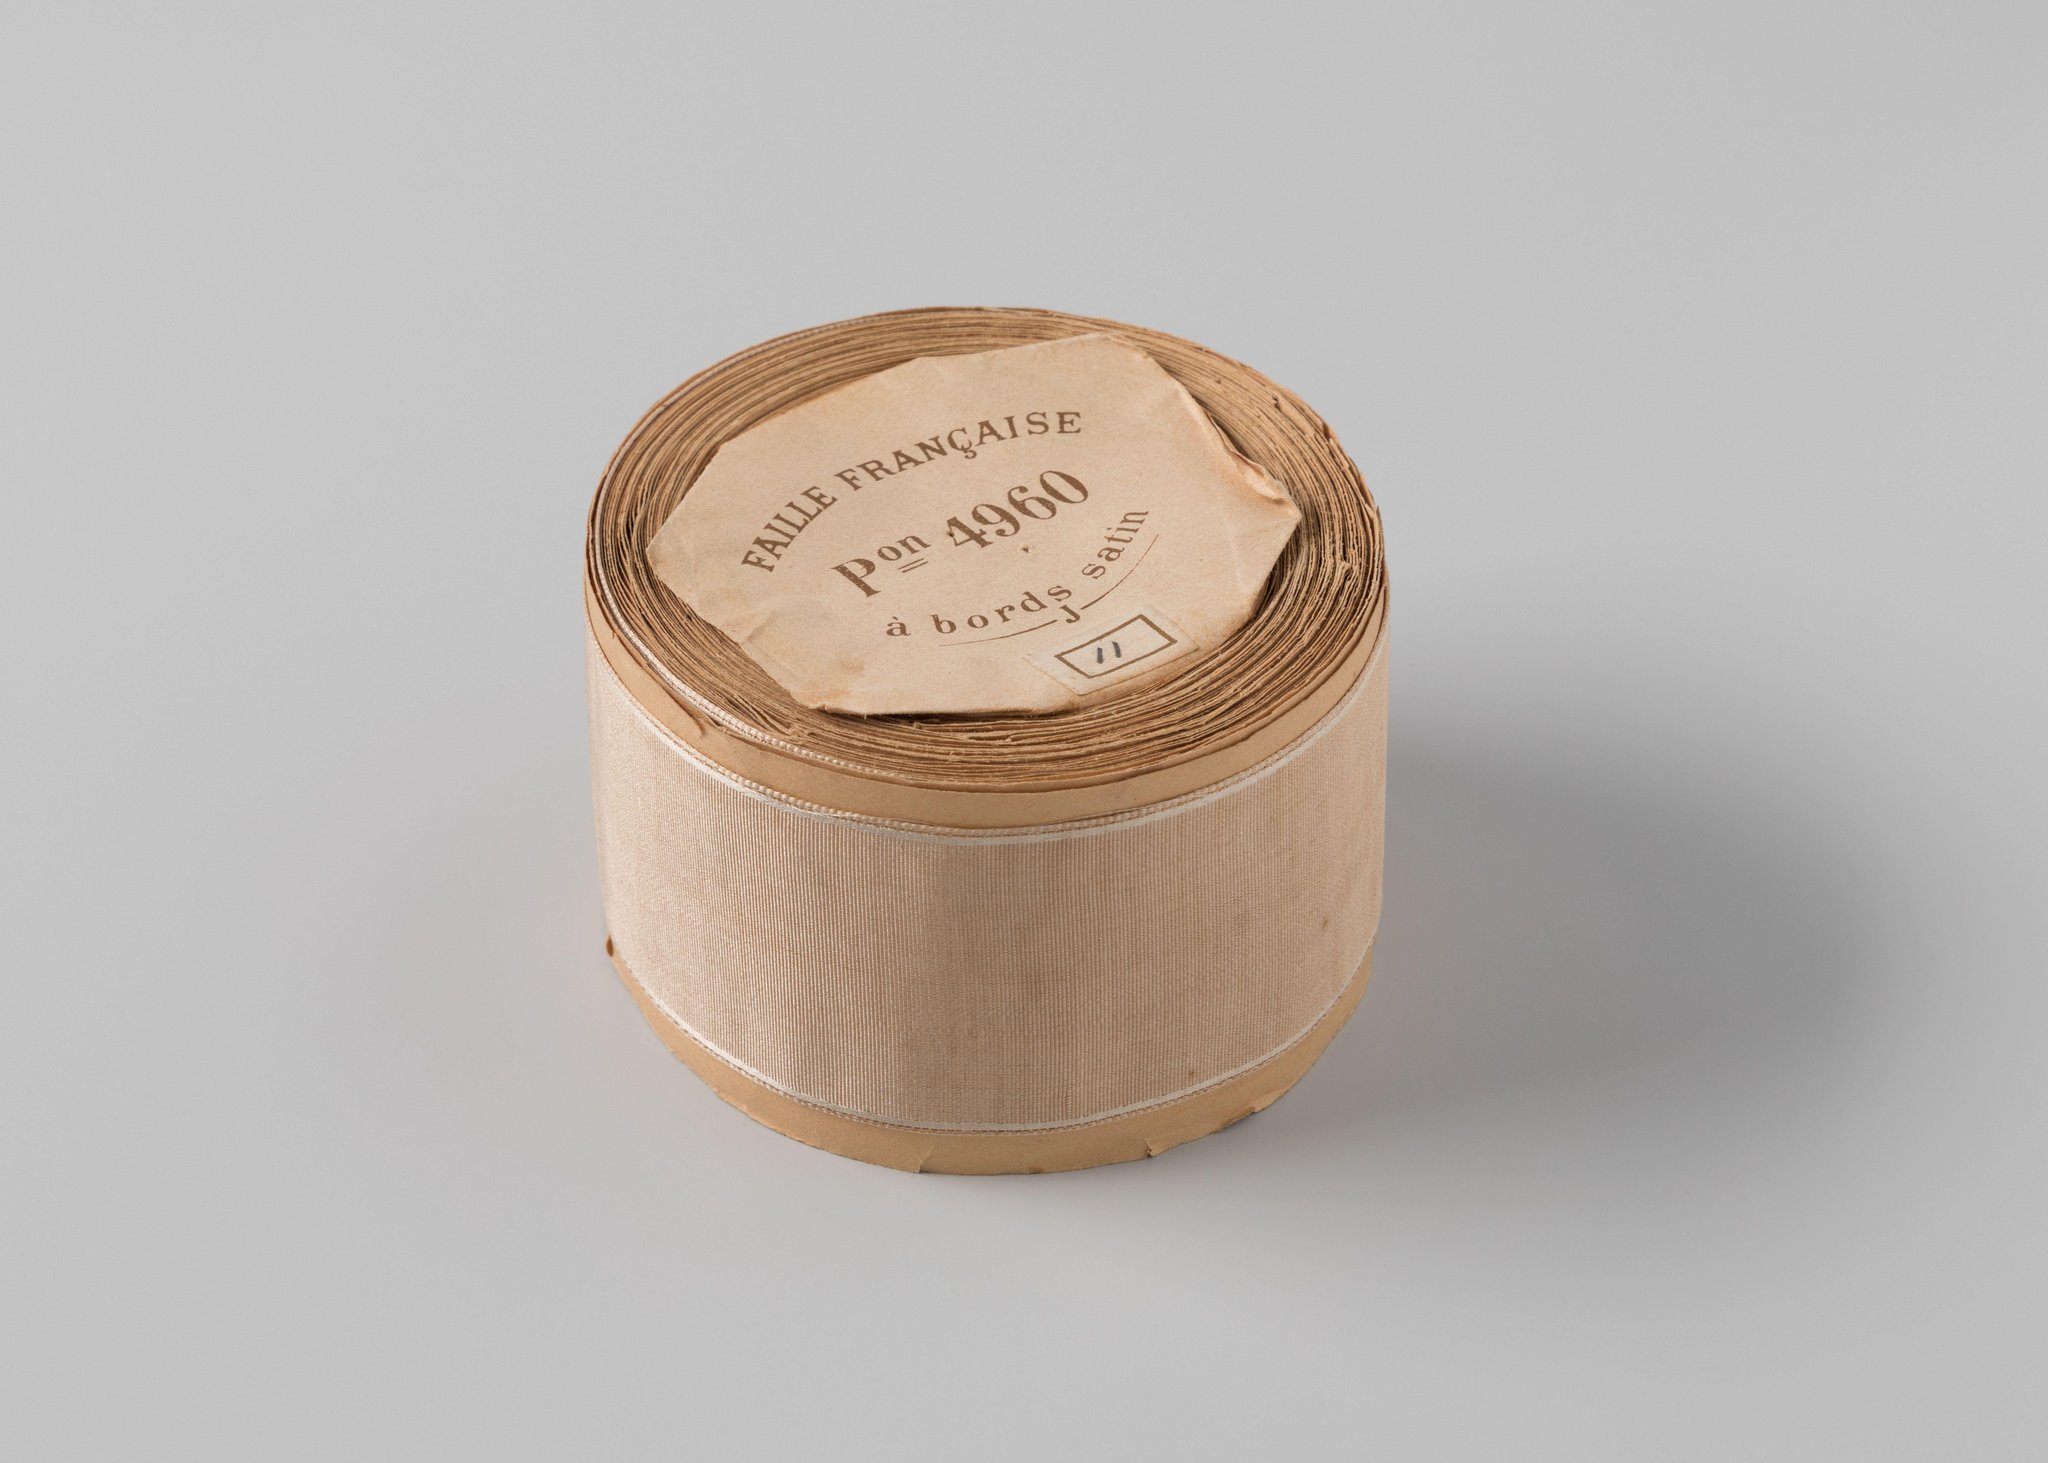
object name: braid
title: Rol met crème zijden satijnlint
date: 1925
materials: cardboard, silk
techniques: satin binding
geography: france